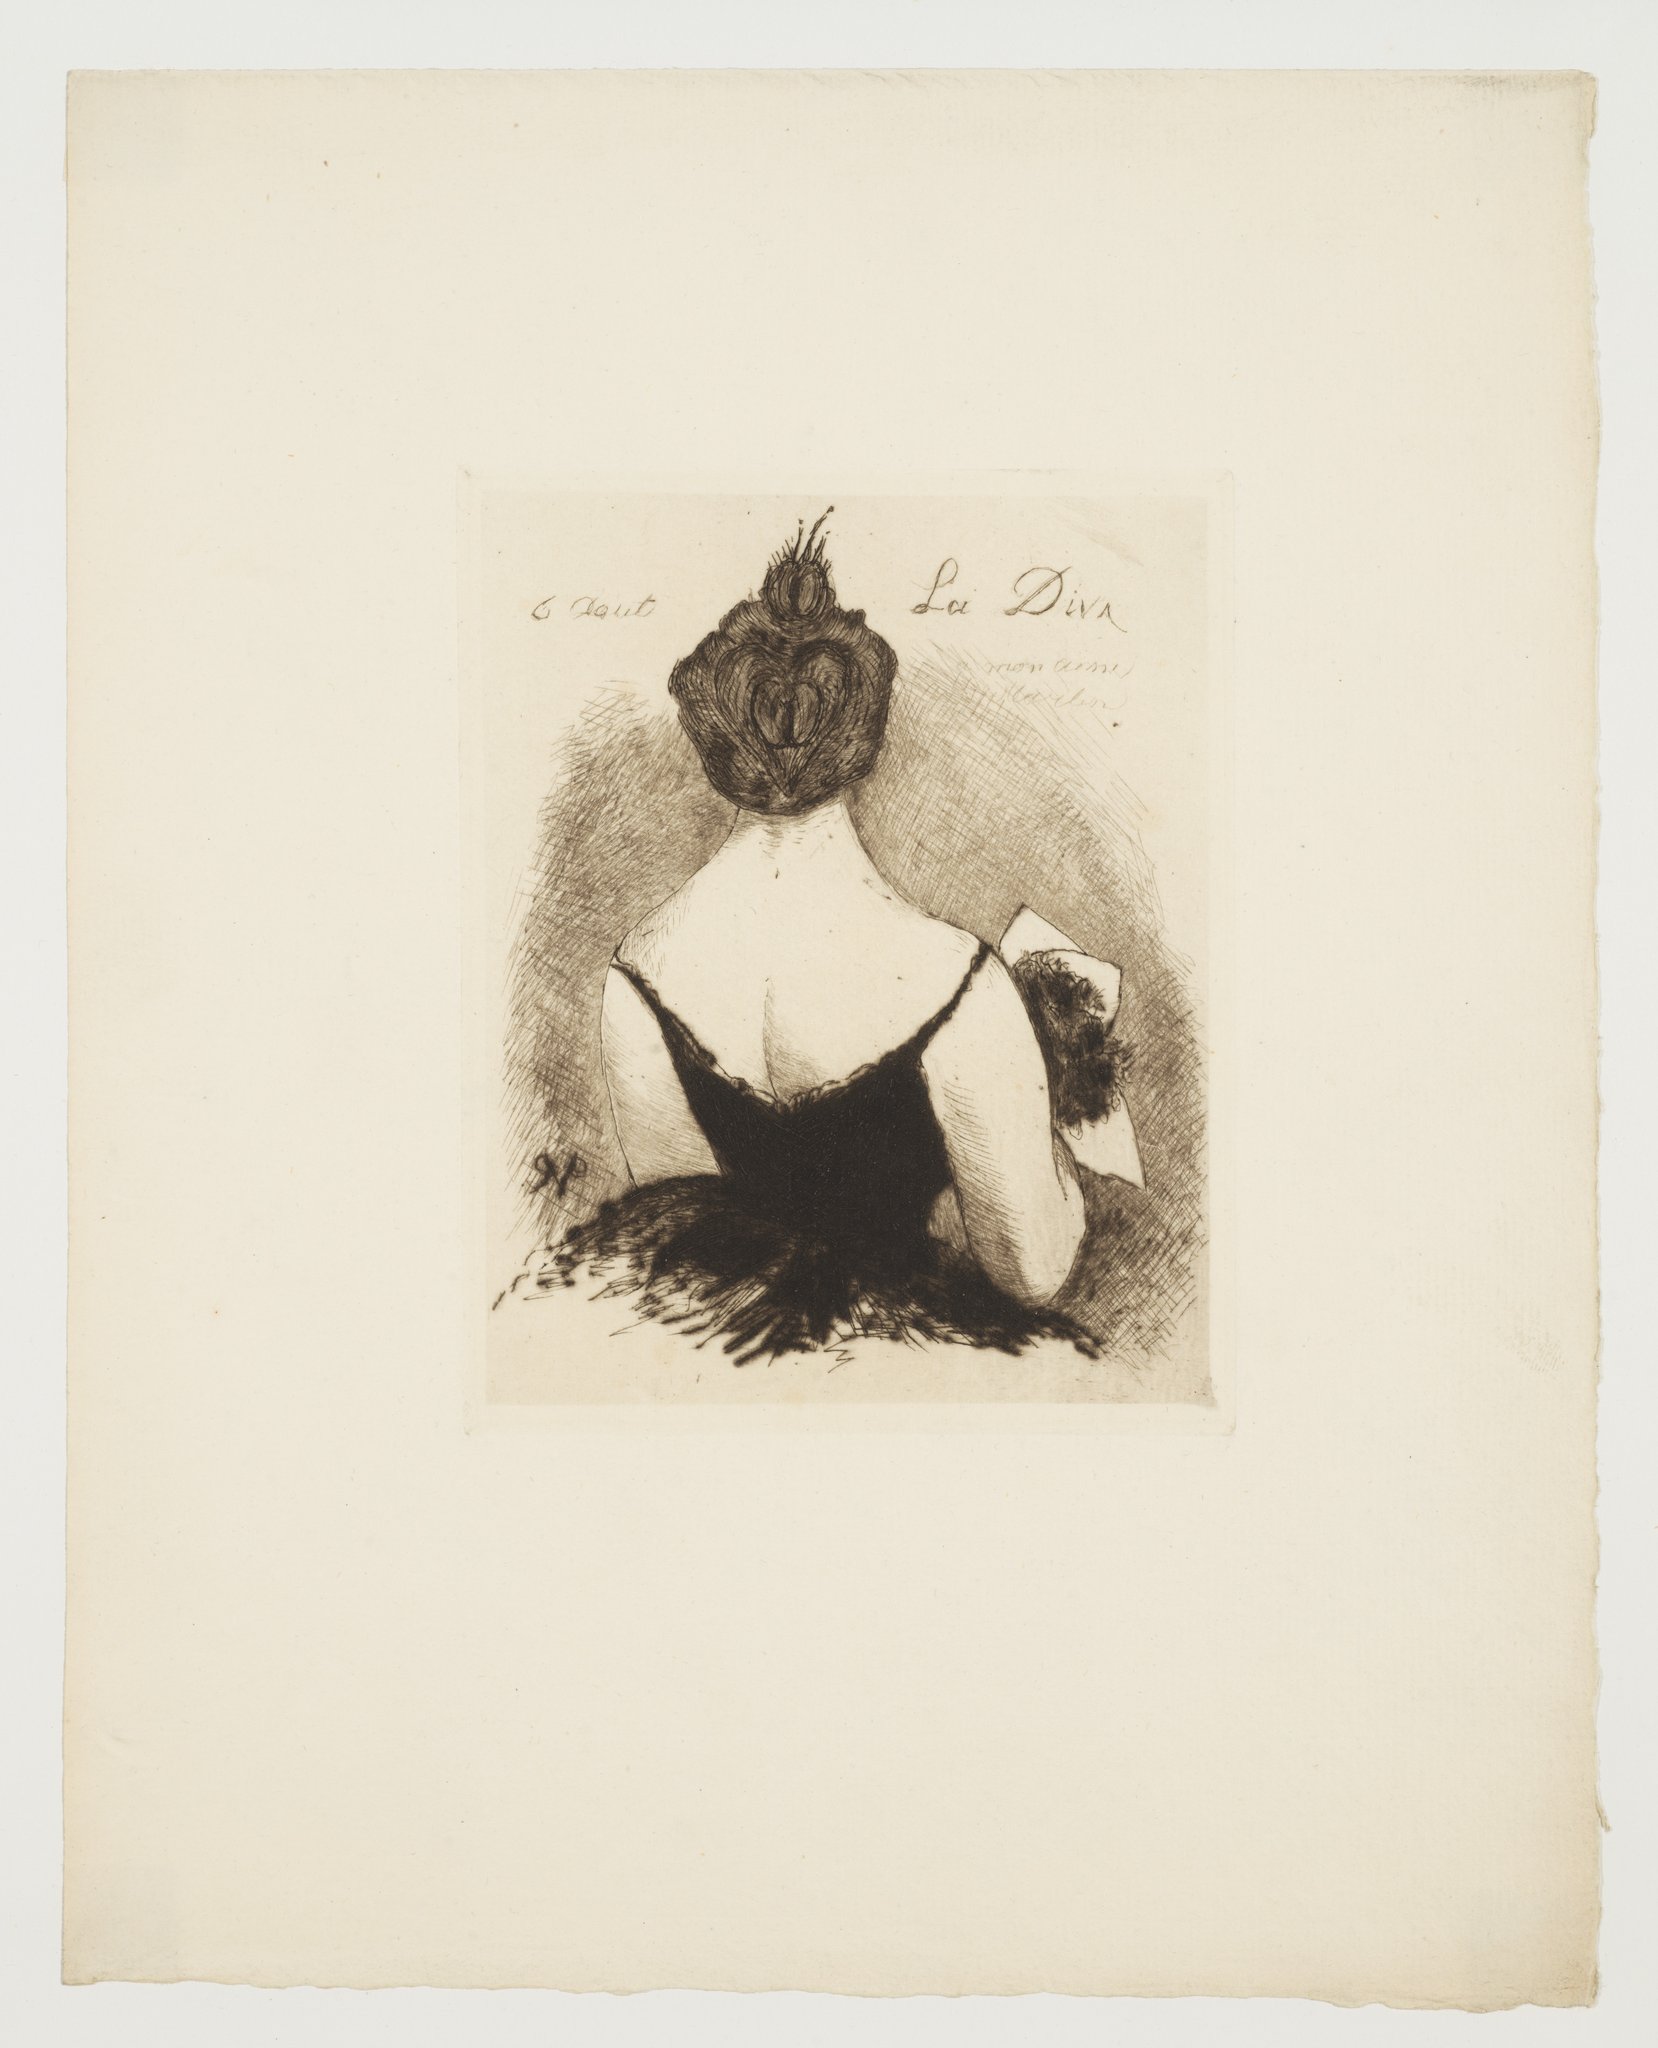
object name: print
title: The Diva (La Diva)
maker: dr. paul gachet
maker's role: artist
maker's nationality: french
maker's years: 1828-1909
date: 1888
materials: paper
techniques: drypoint, etching